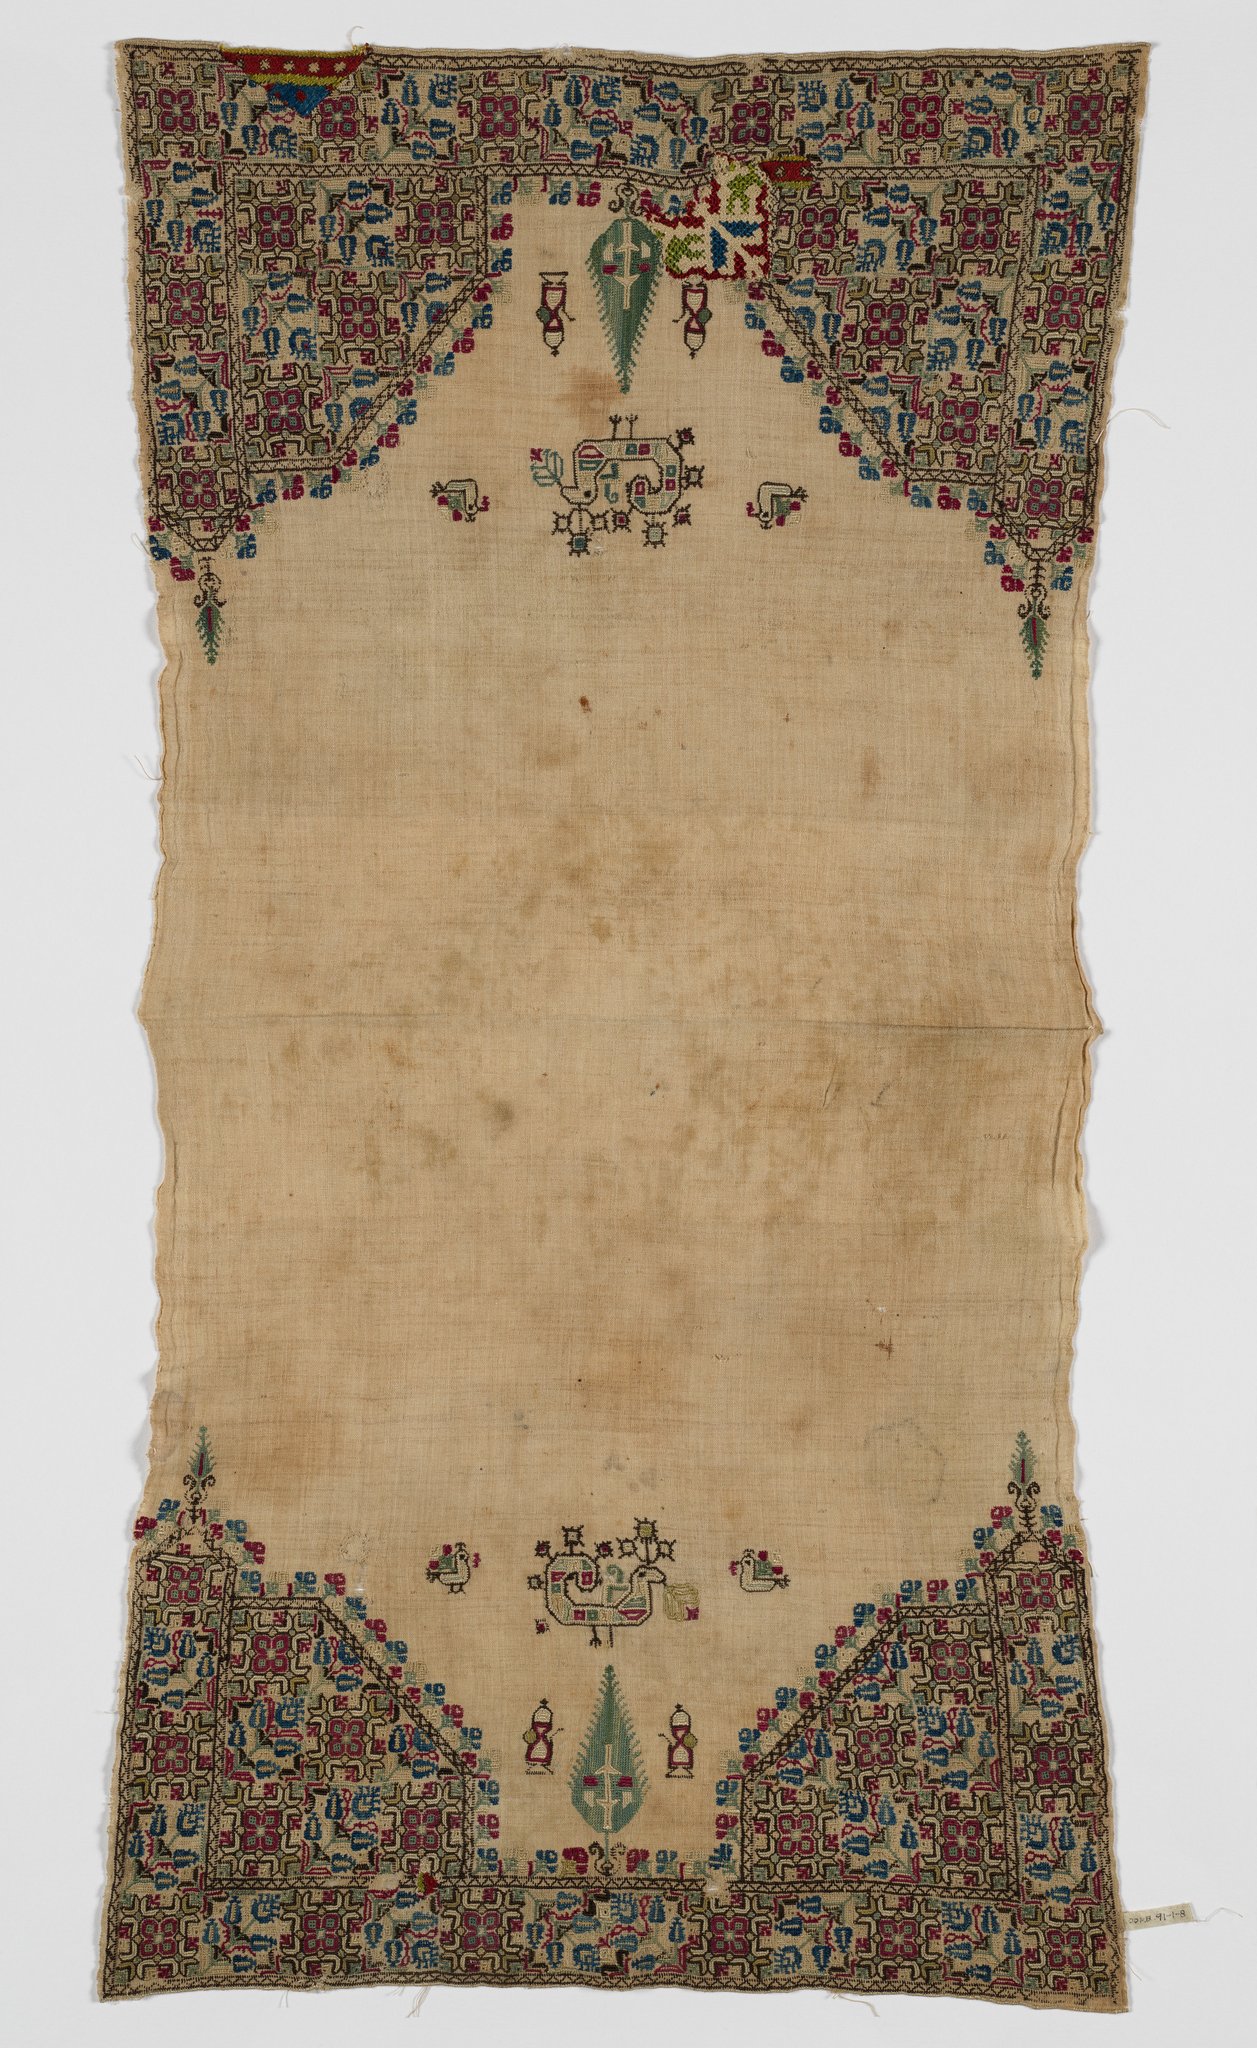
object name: towel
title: Napkin or Hand Towel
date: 1701-1800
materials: linen, silk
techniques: embroidery, weave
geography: albania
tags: birds